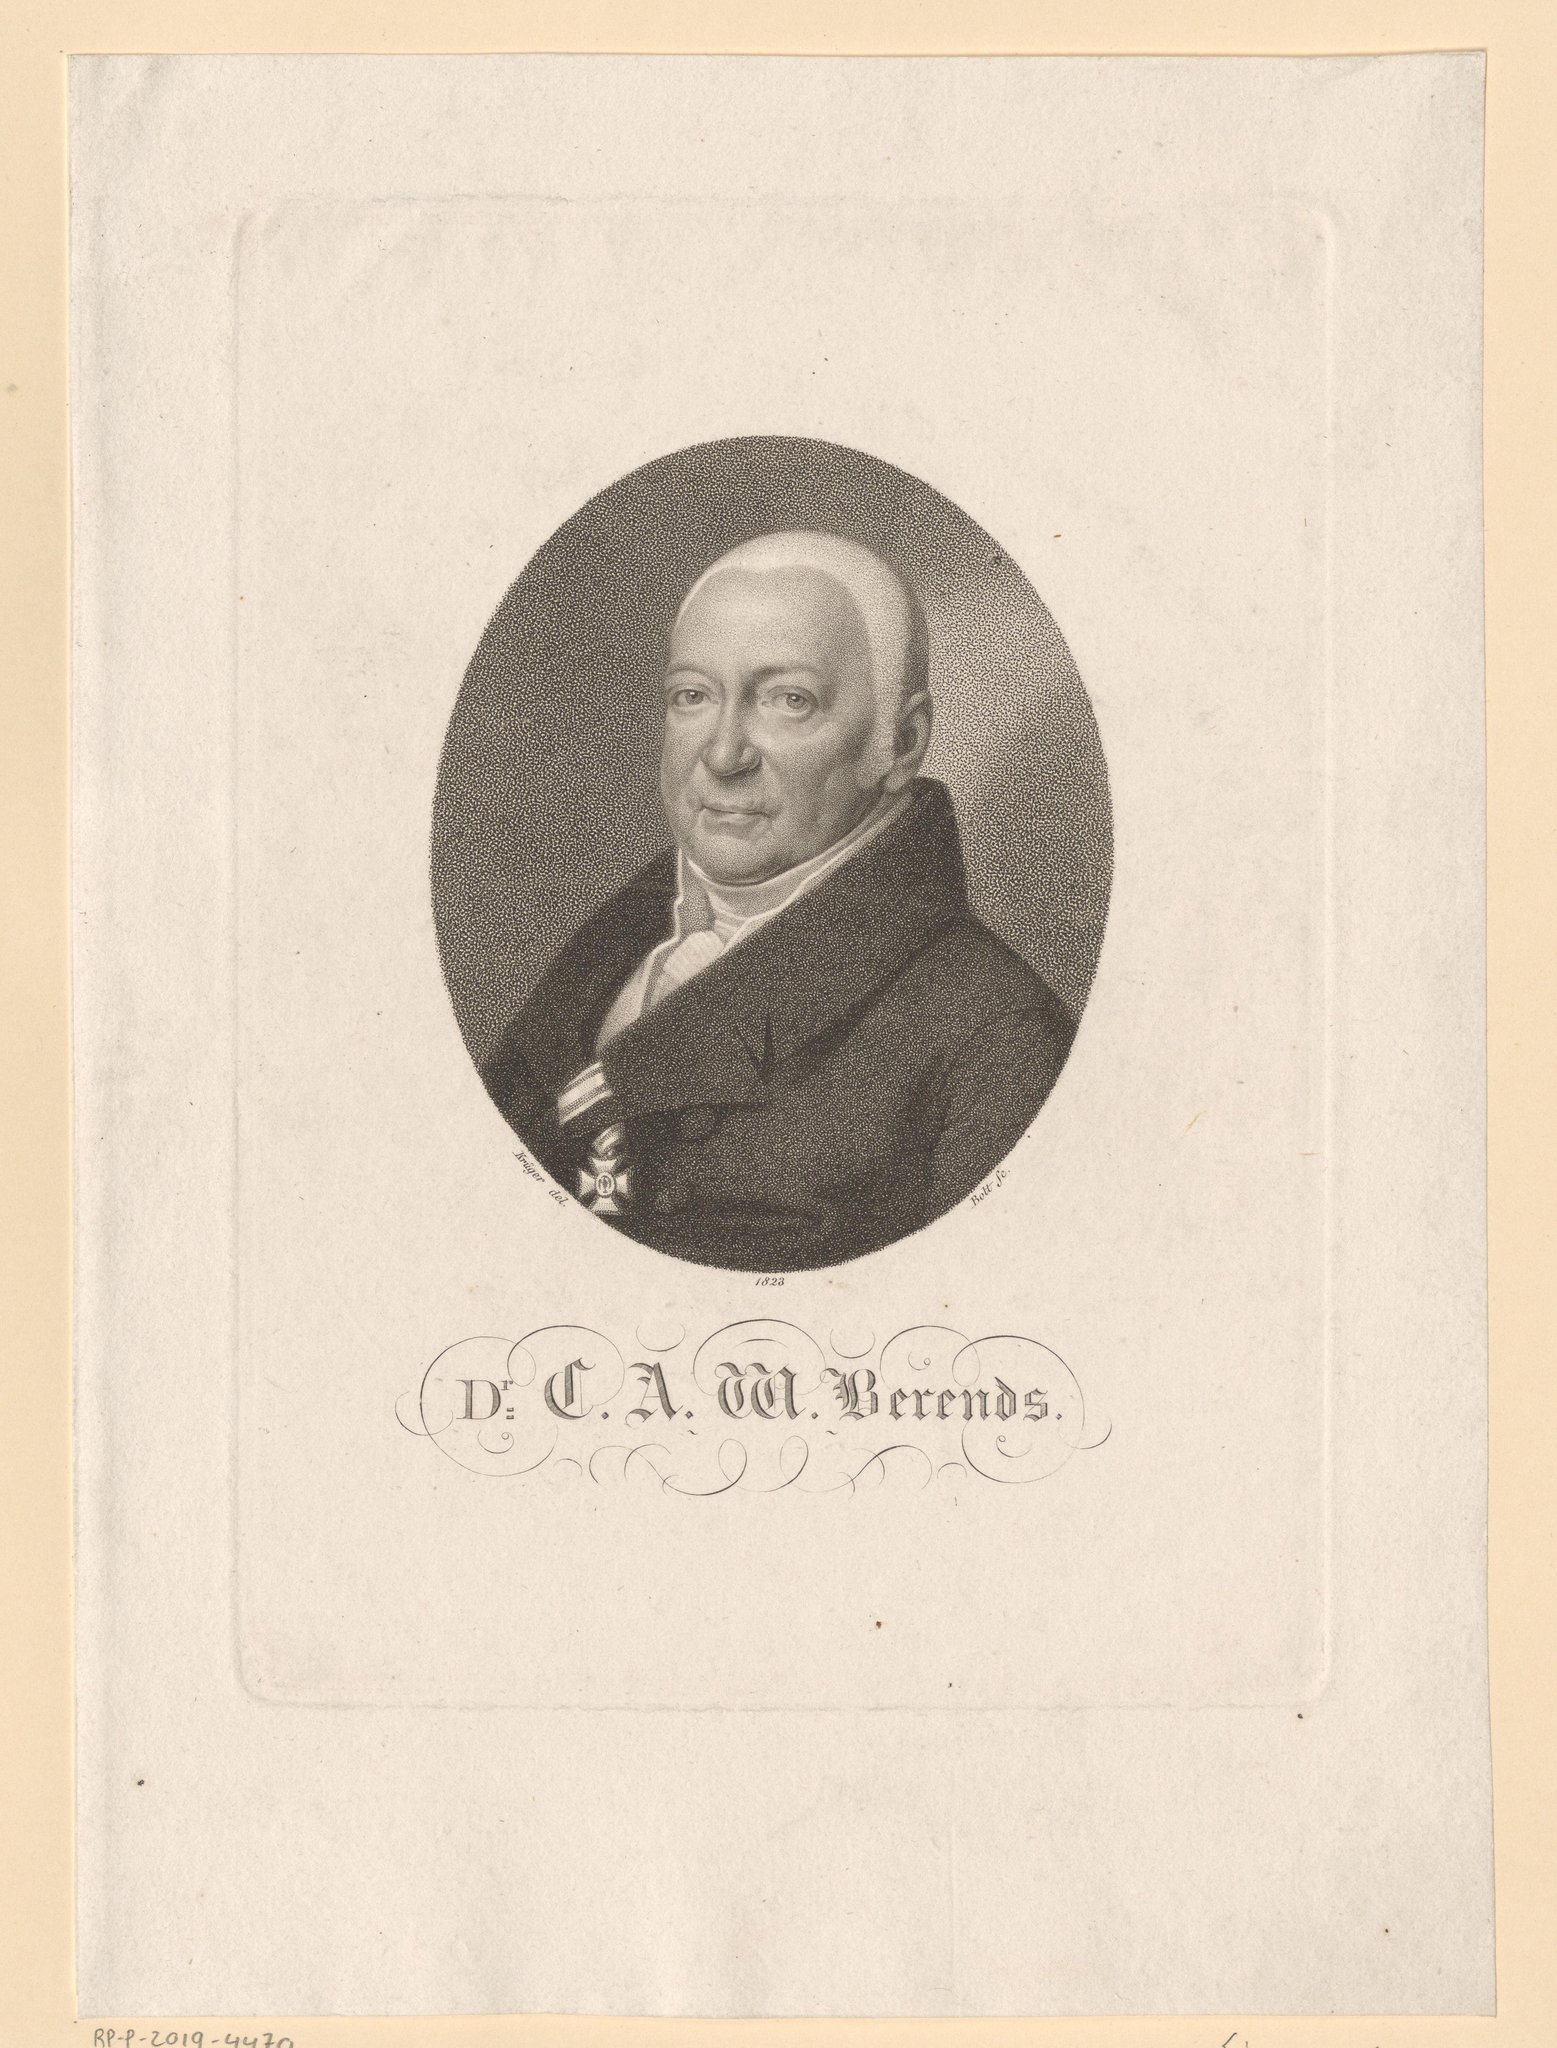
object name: print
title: Portret van Karl August Wilhelm Berends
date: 1823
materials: paper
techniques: etching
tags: berlin, historical persons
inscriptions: date